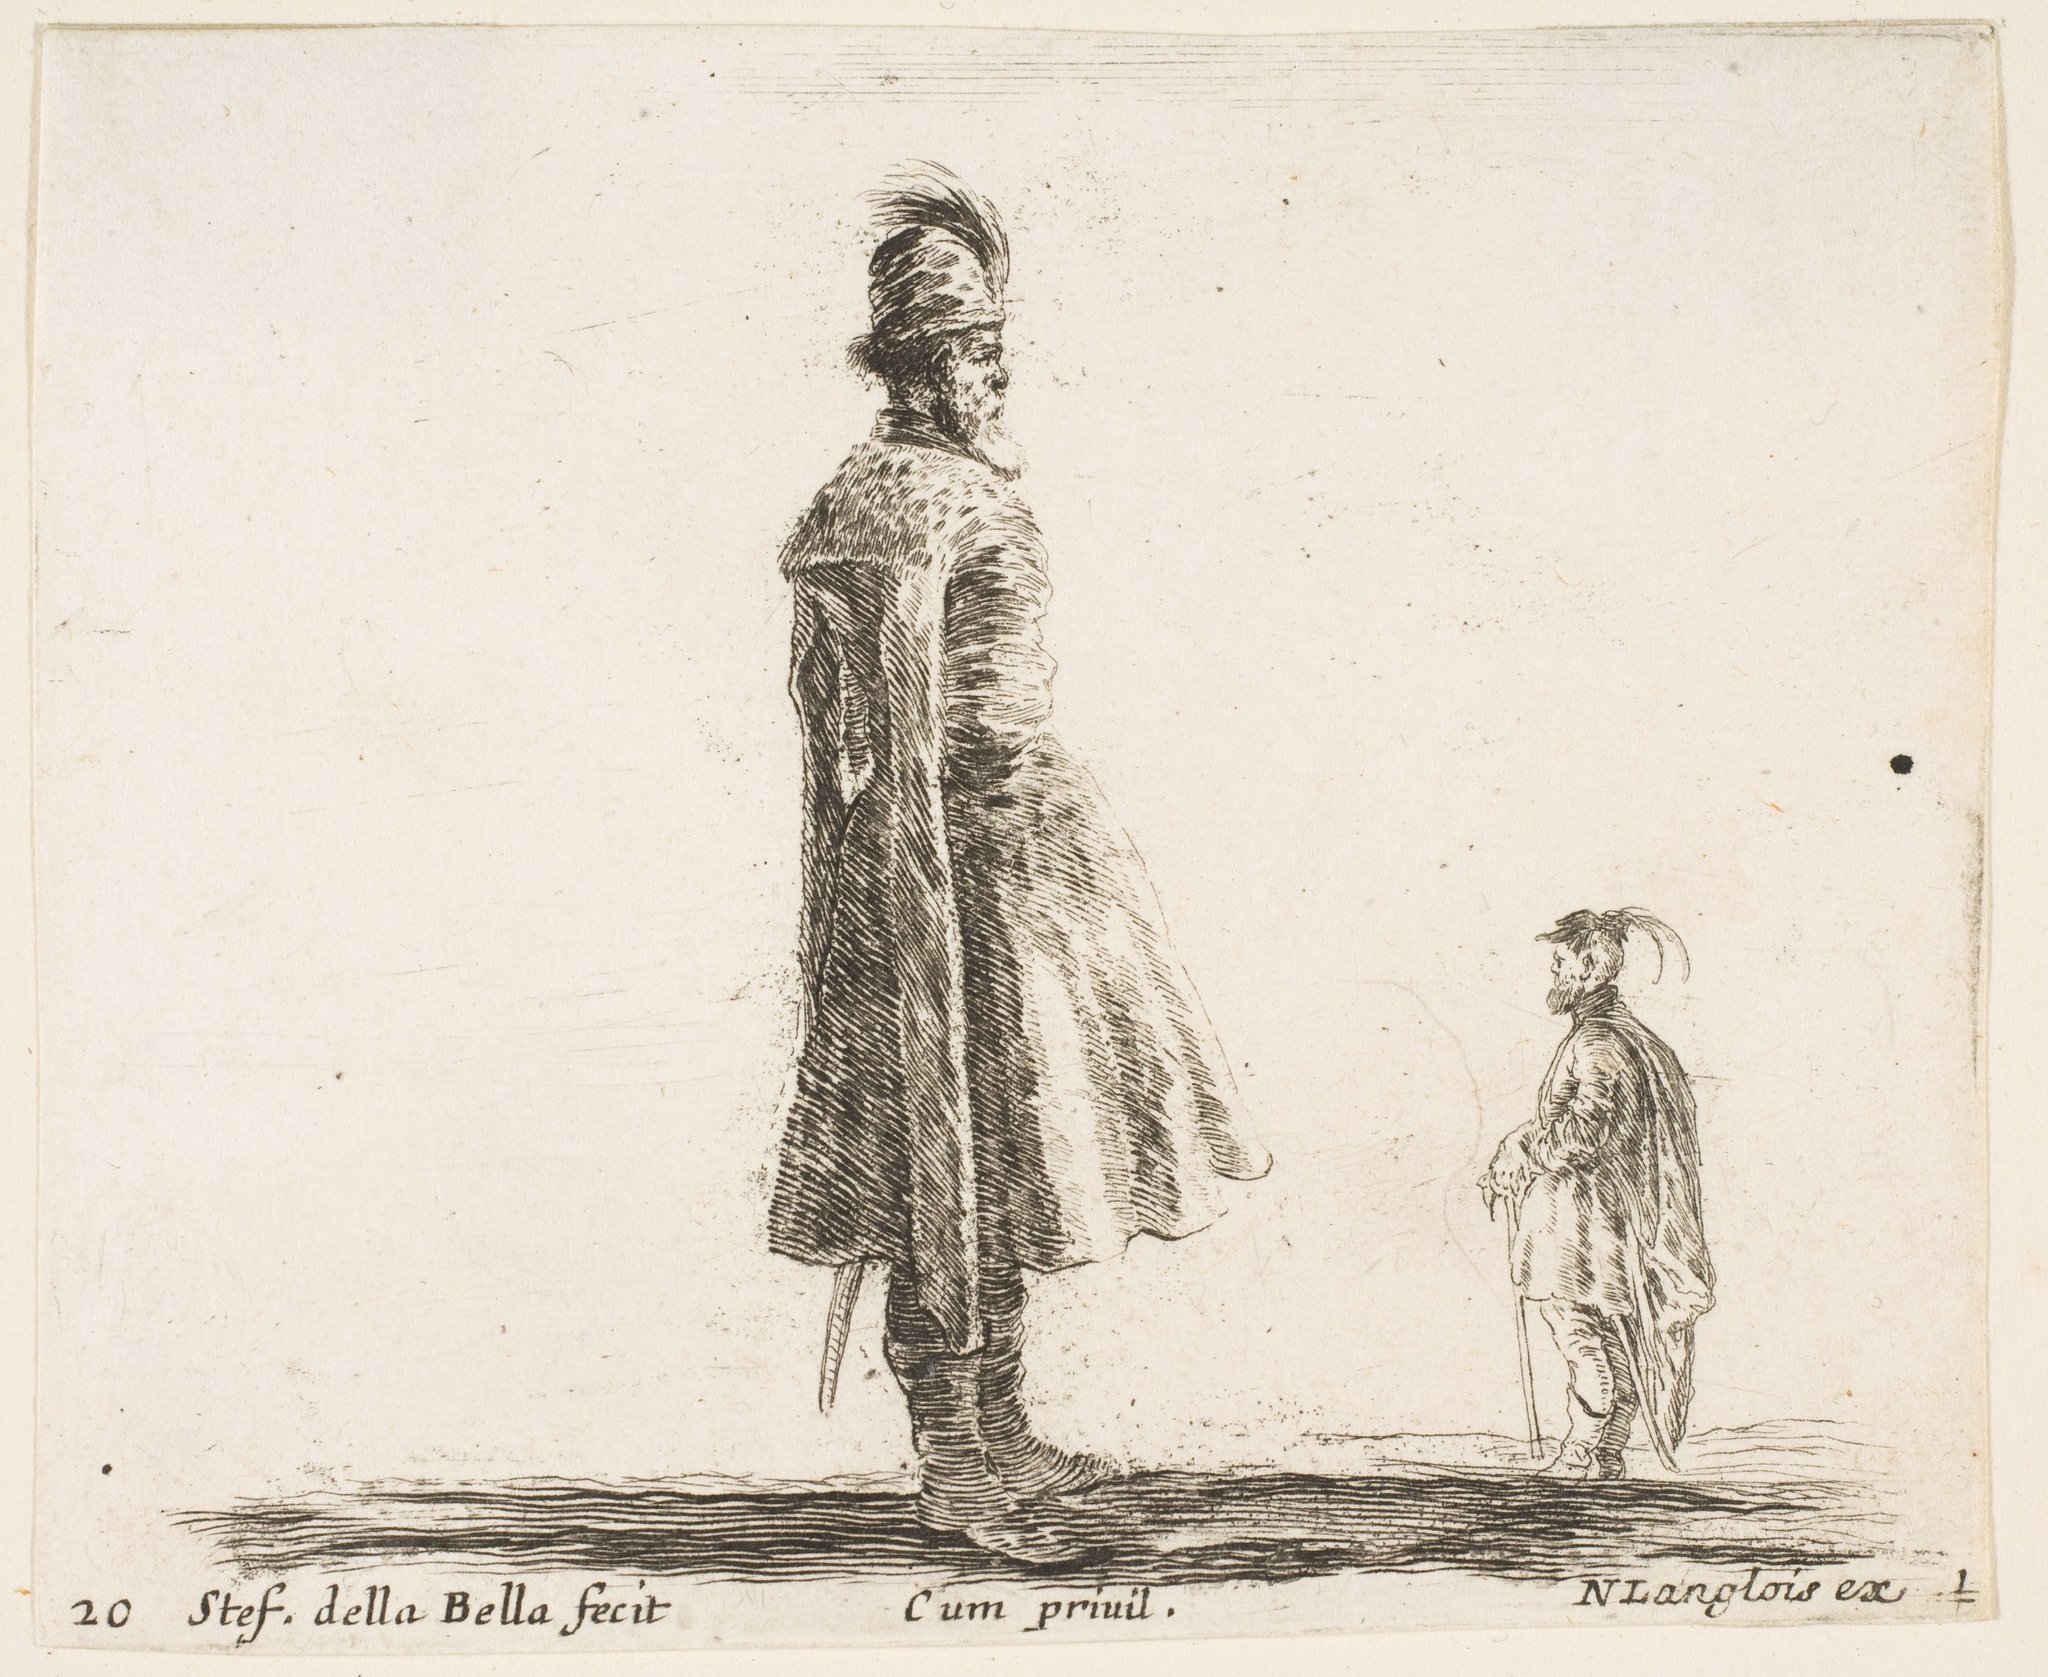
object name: print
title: An old Polish nobleman wearing a plumed hat in center, standing in profile facing right, another Polish man to right in background, standing in profile facing left, plate 20 from "Diversi capricci"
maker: stefano della bella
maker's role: artist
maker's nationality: italian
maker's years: 1610-1664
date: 1644-1647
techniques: etching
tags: men,profiles